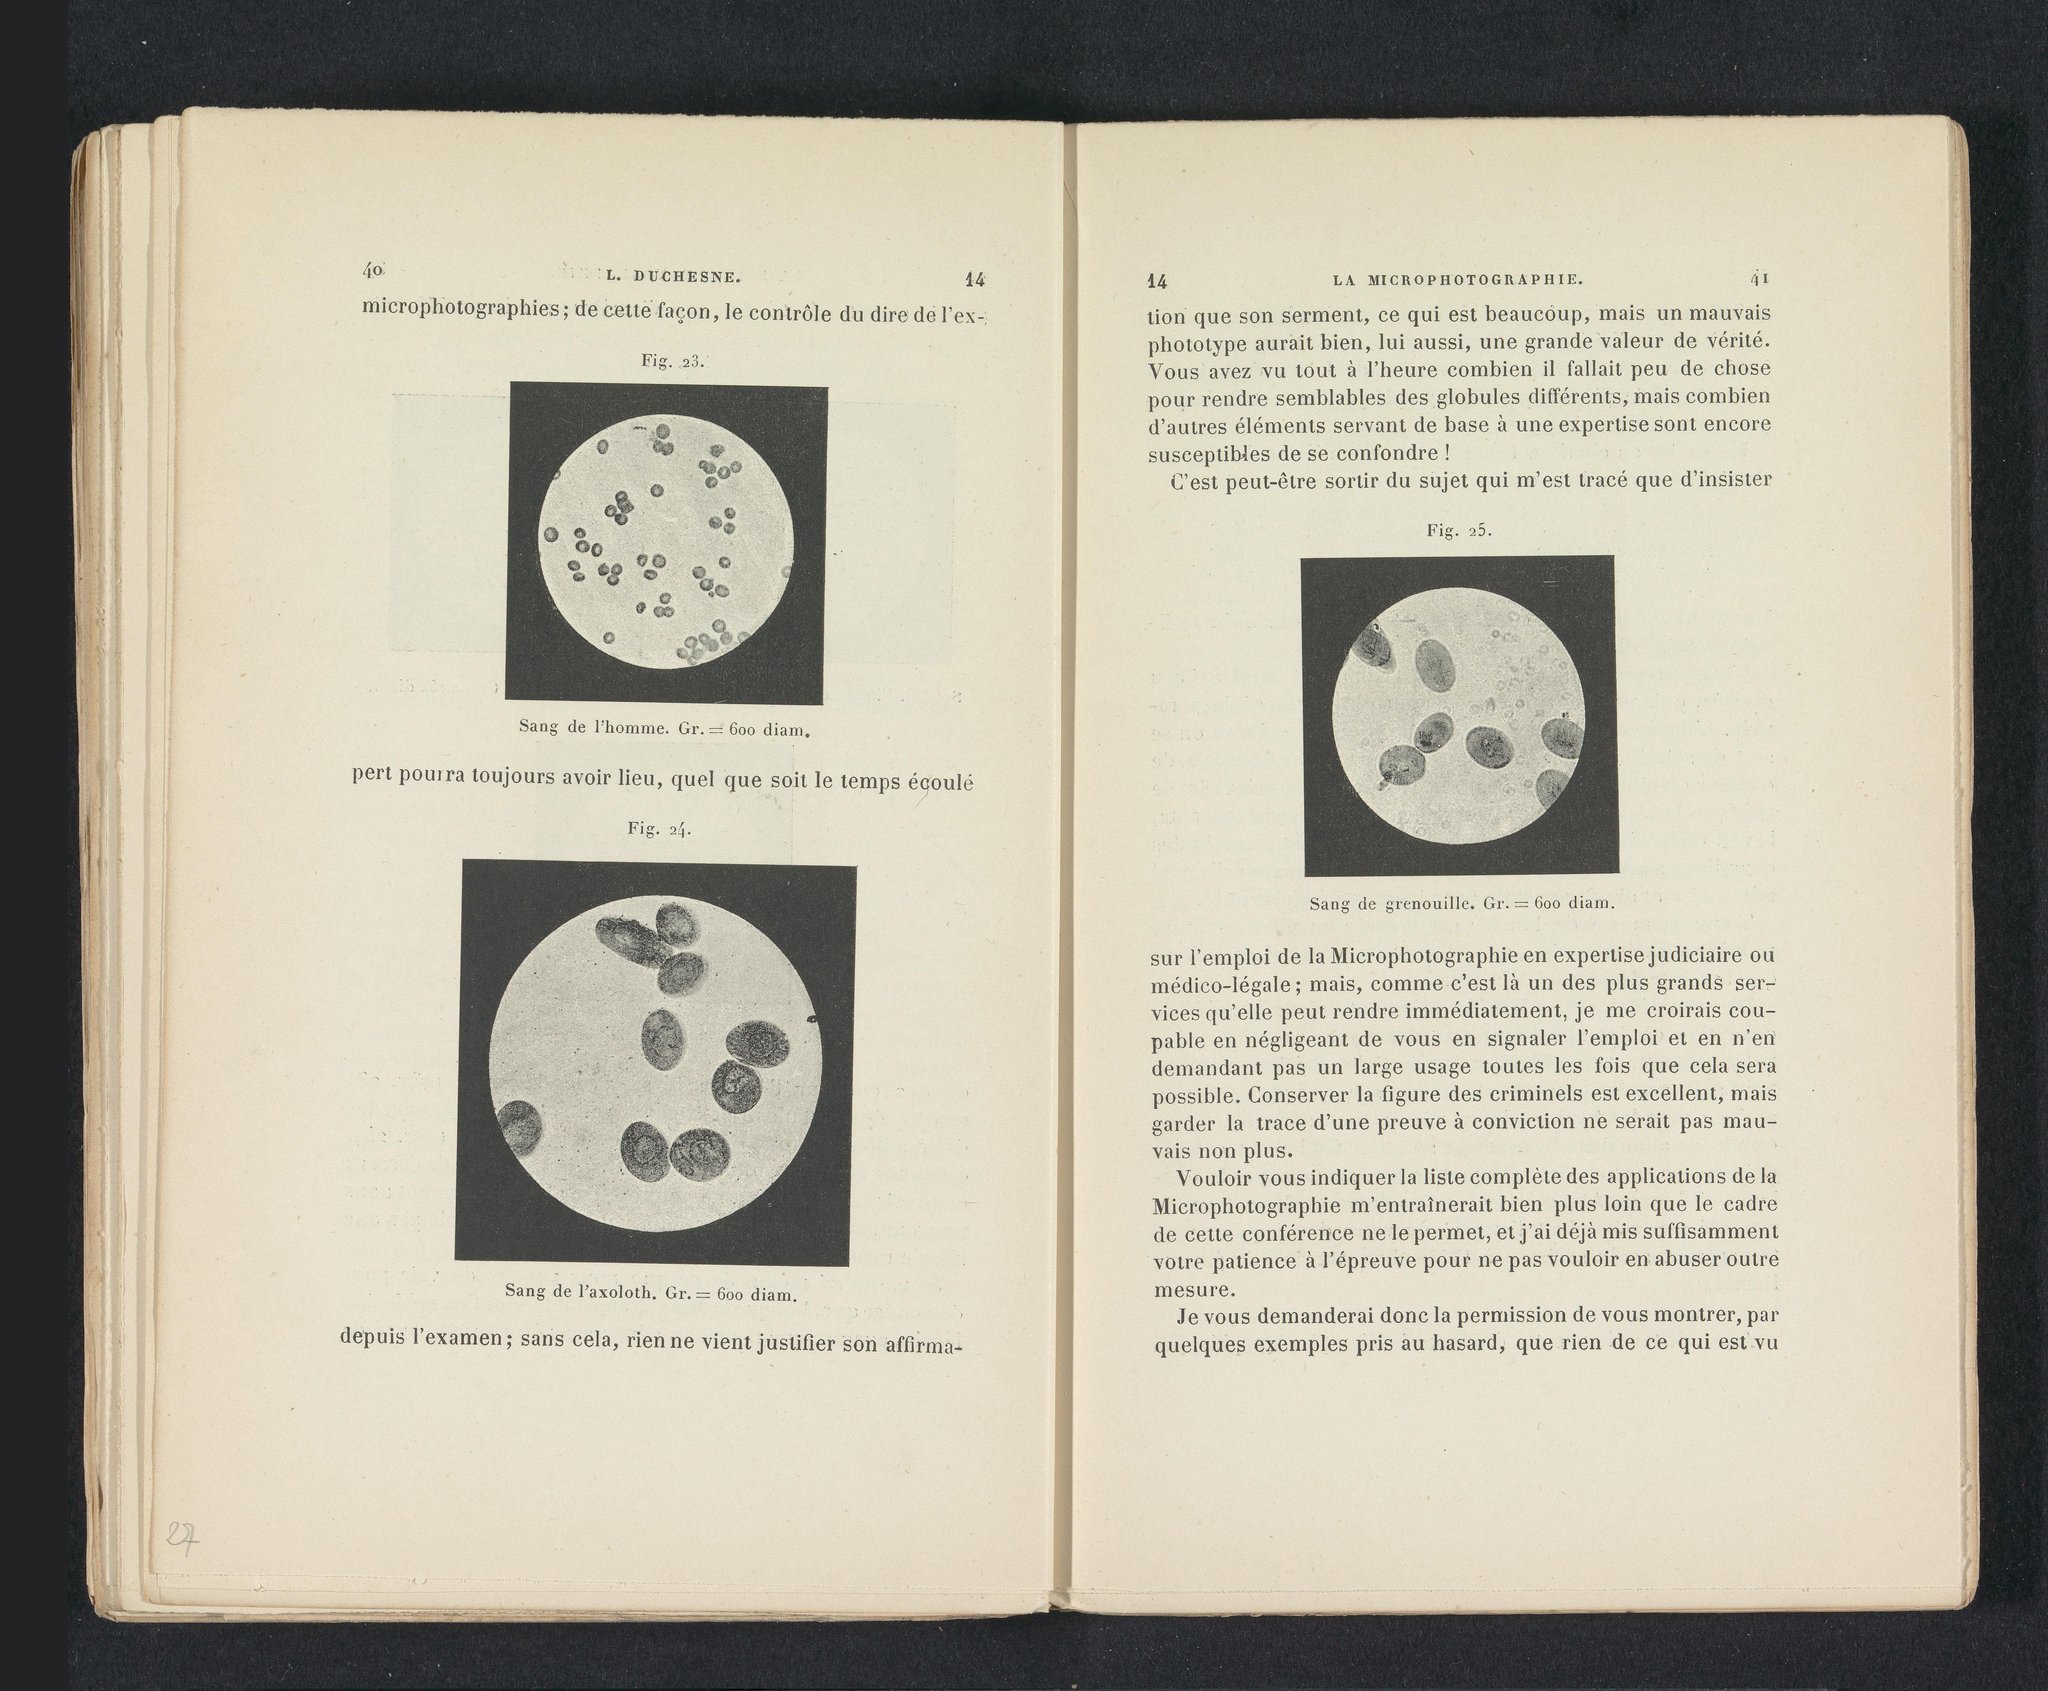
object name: page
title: Twee vergrotingen van het bloed van een mens en een axolotl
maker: Anonymous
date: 1883-1893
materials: paper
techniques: autotype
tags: blood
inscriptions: inscription: ‘Sang de l'homme (...) Gr. = 600 diam.’, number: ‘Fig. 23. (...) Fig. 24.’